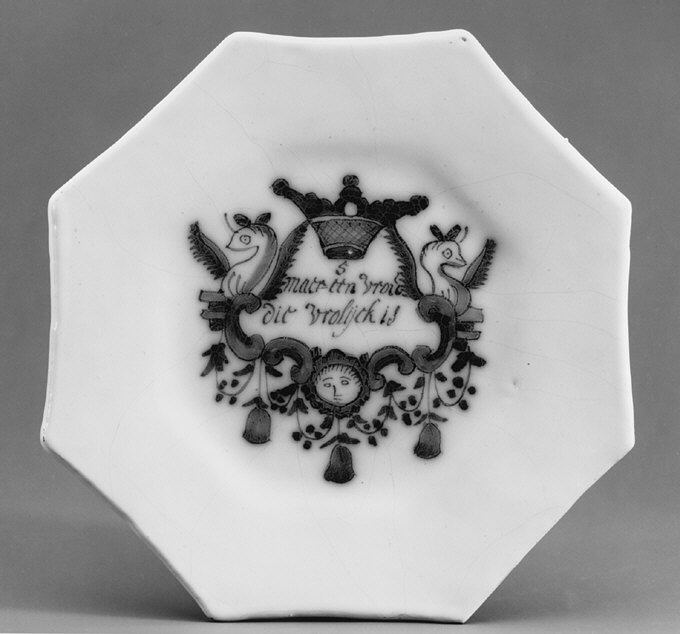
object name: plate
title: Plate (part of a set)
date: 1660-1690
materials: earthenware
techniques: glazing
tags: coat of arms